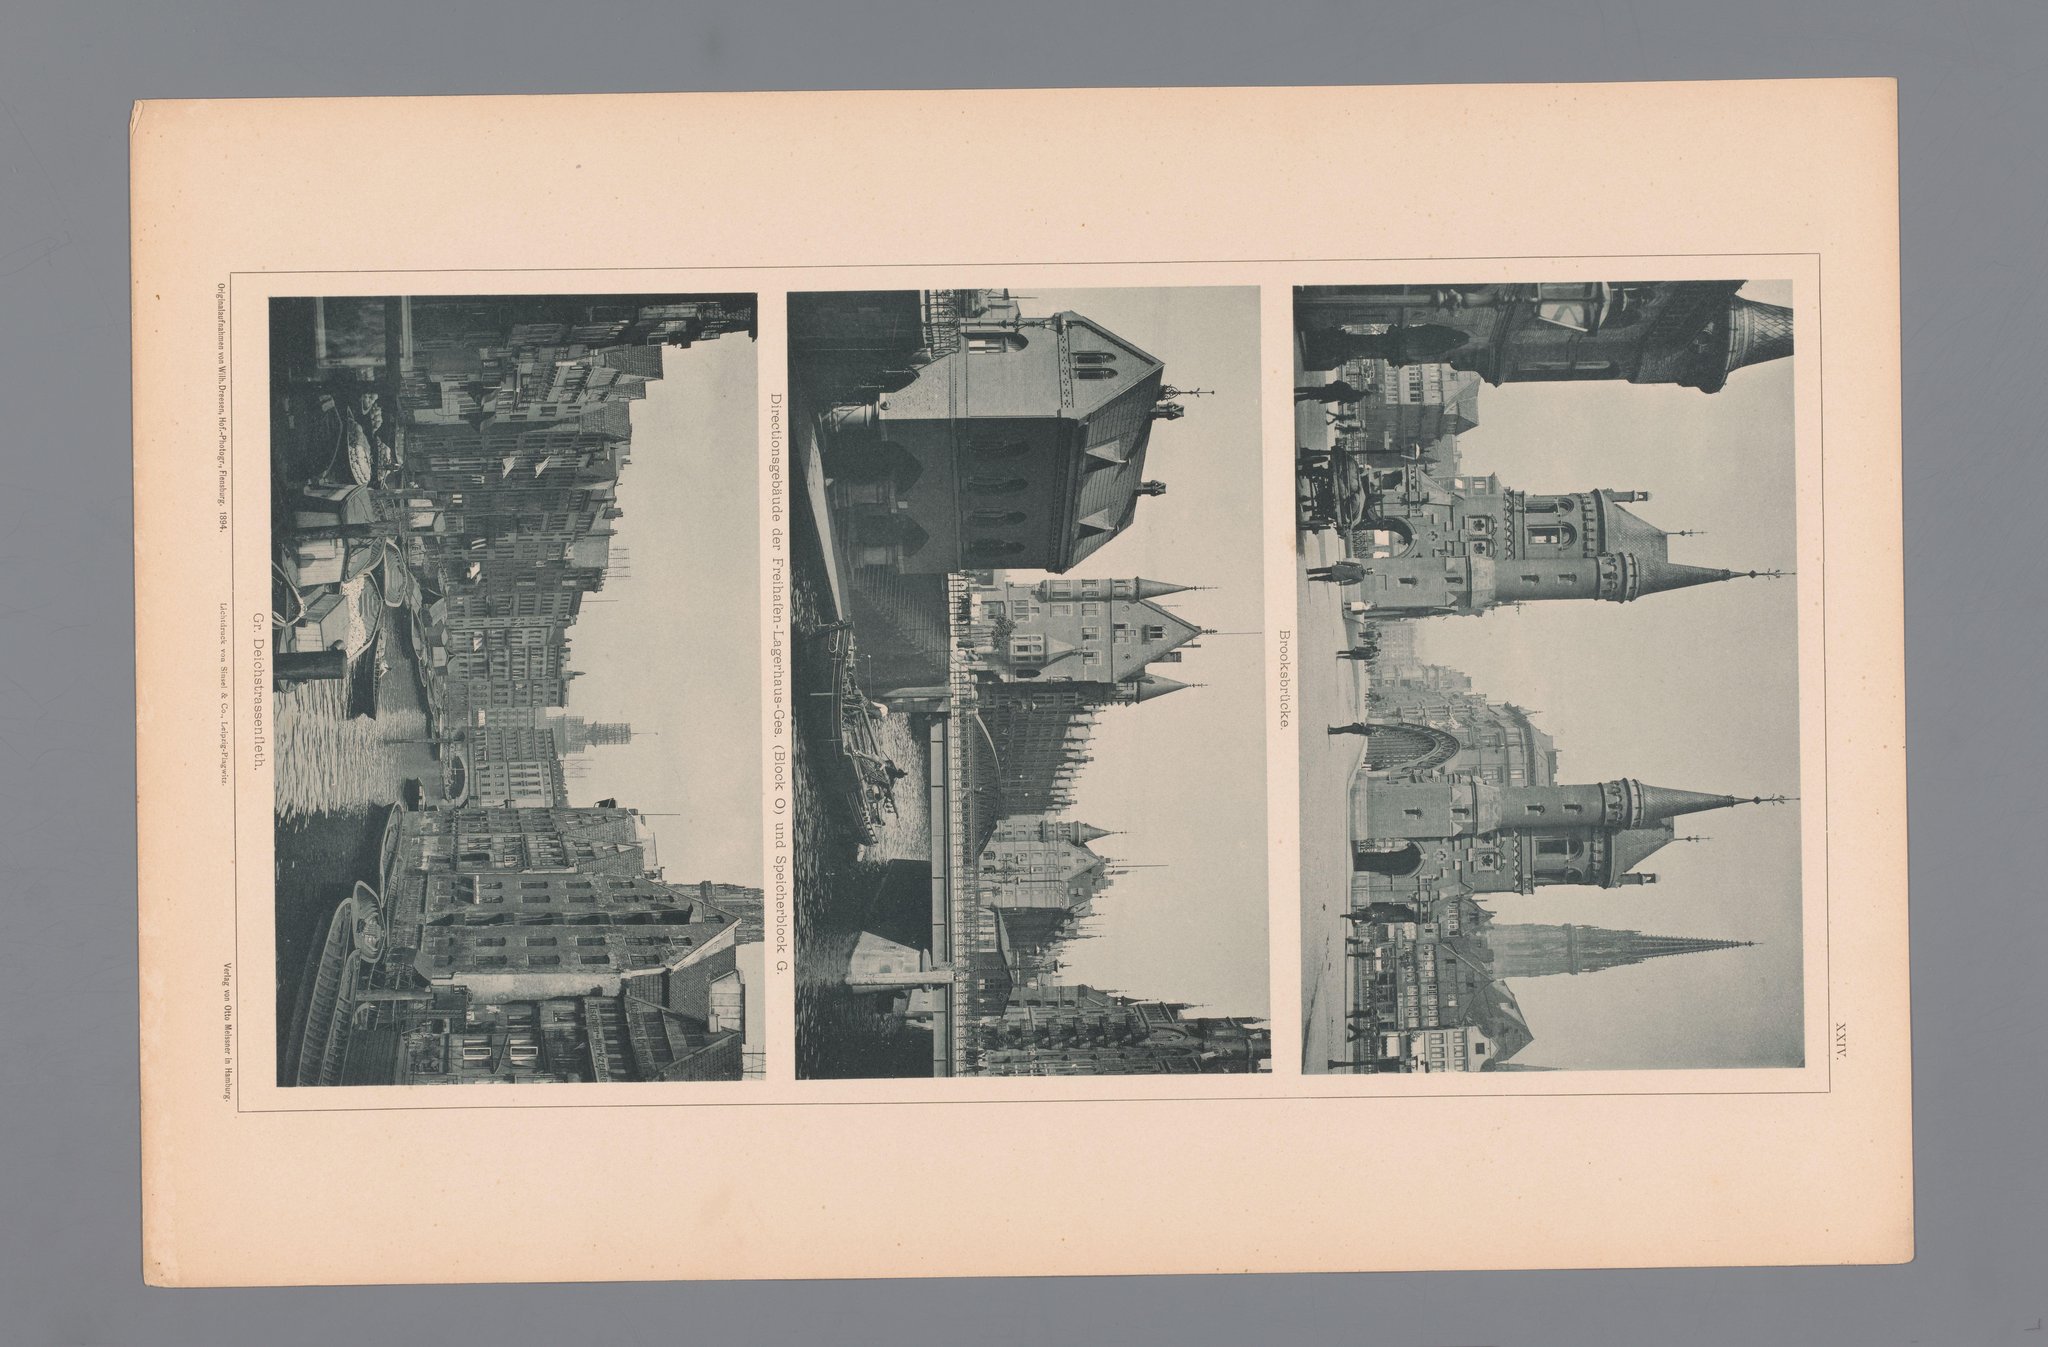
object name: photomechanical print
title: Drie gezichten op Hamburg, afgebeeld de Brooksbrücke, een bestuursgebouw en de Deichstrassenfleth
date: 1894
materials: paper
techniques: photograph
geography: hamburg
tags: bridge in city across river, canal, etc., street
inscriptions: number: ‘XXIV.’, inscription: ‘Originalaufnahmen von Wilh. Dreesen, Hof.-Photogr., Flensburg. 1894.’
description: Deze prenten maken deel uit van een omslag met 126 prenten op 37 bladen en een tekstblad.